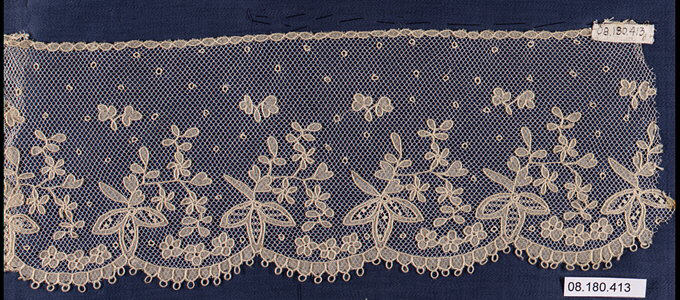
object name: fragment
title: Fragment of Carrickmacross lace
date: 1801-1900